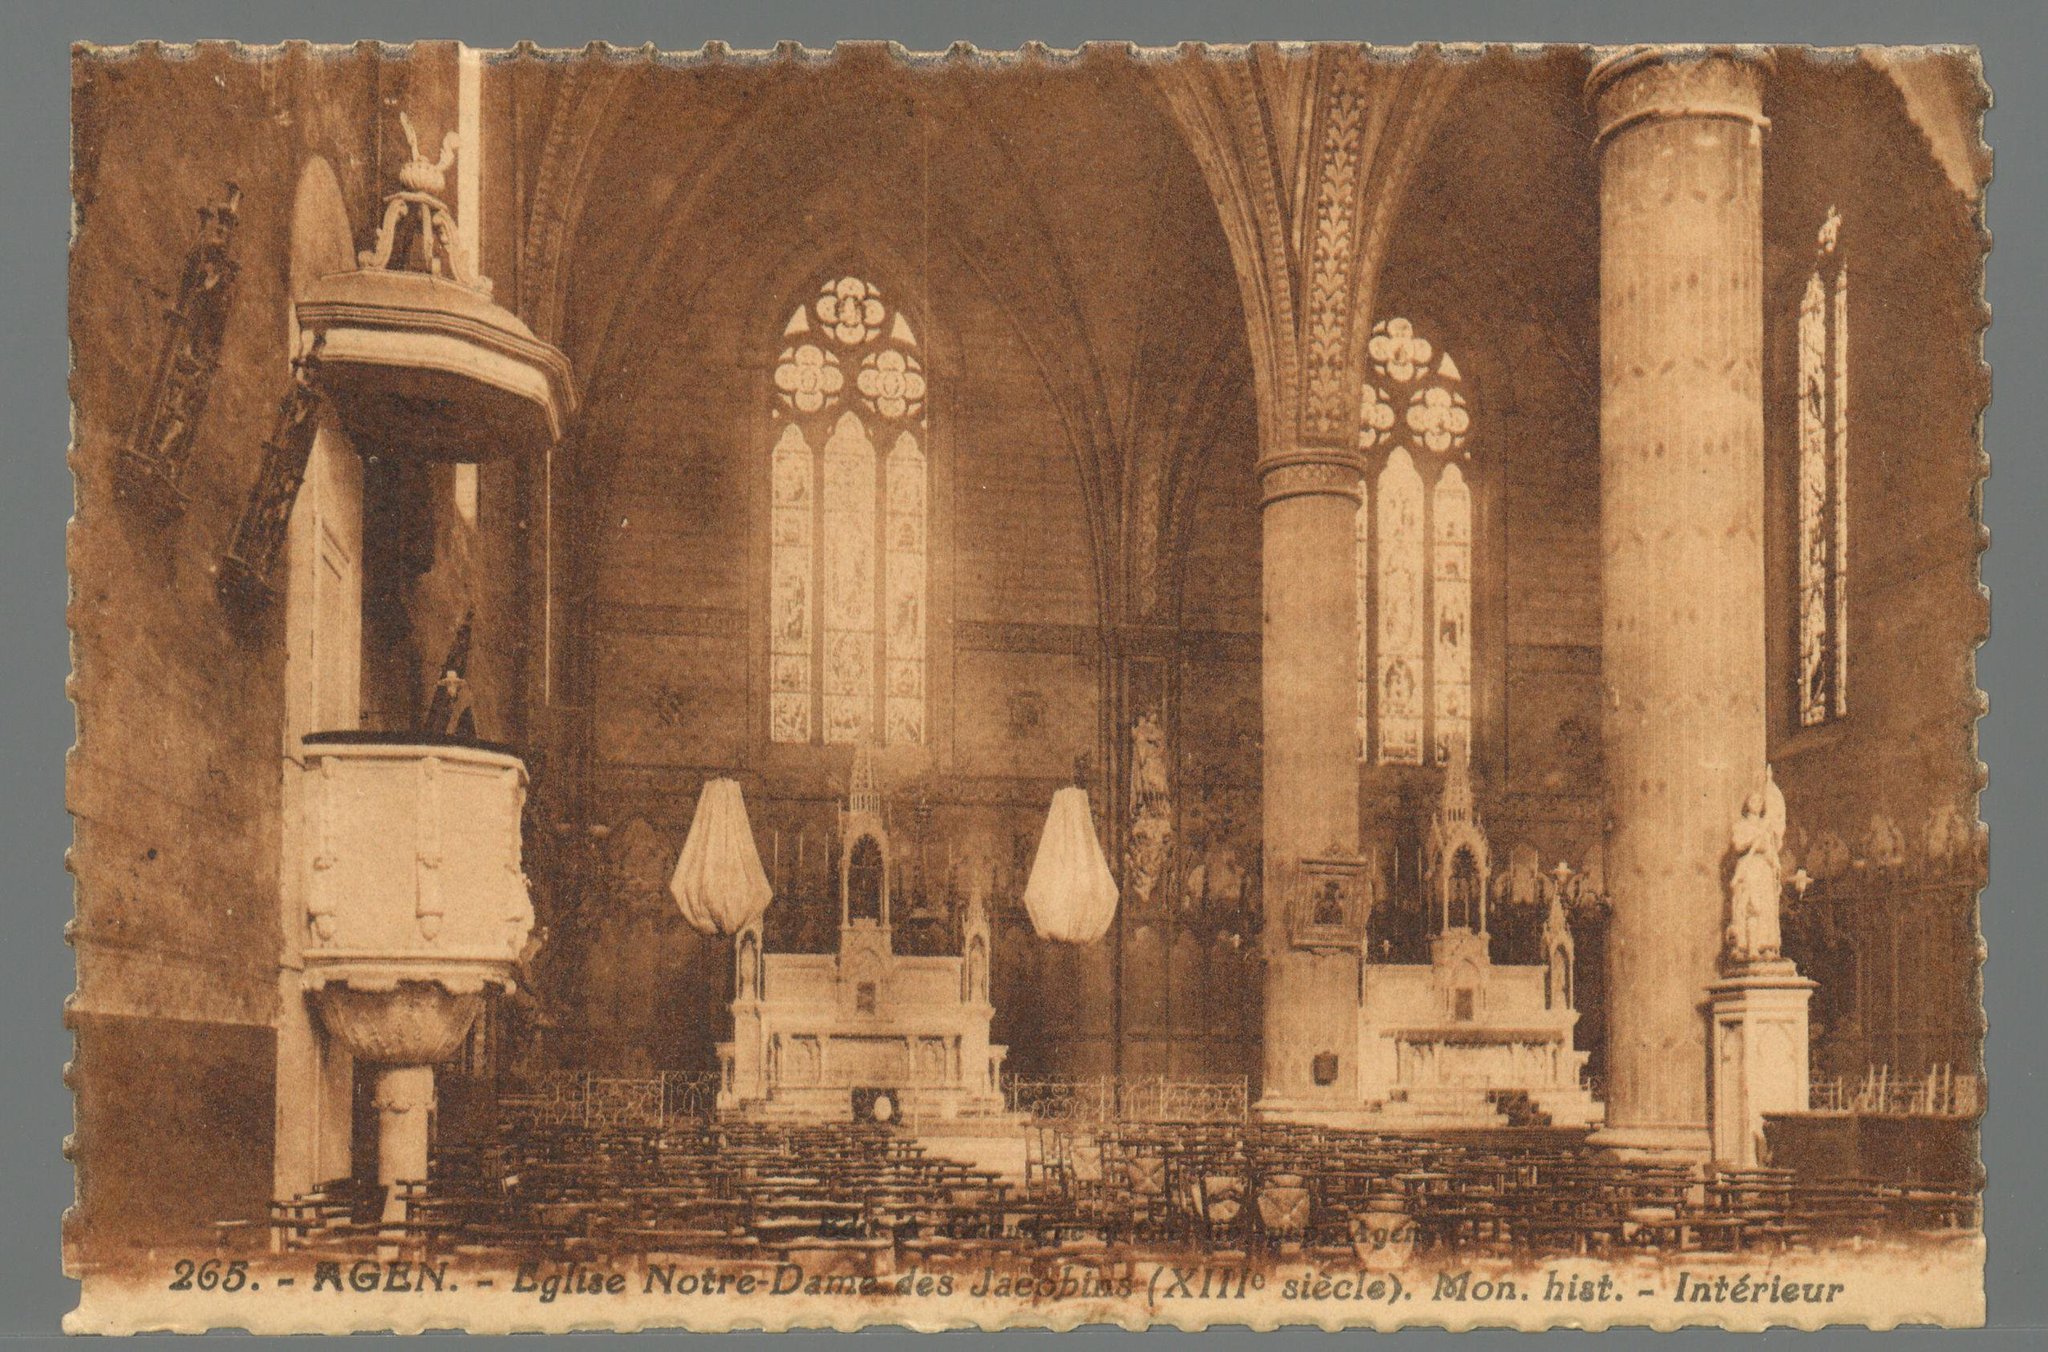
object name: photomechanical print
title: Agen - Eglise Notre-Dame des Jaephins (XIIIe siècle). Mon. hist. - Intérieur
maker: Anonymous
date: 1903-1932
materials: cardboard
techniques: photograph, writing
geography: agen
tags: interior of church, pulpit, ambo, chancel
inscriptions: postage stamp